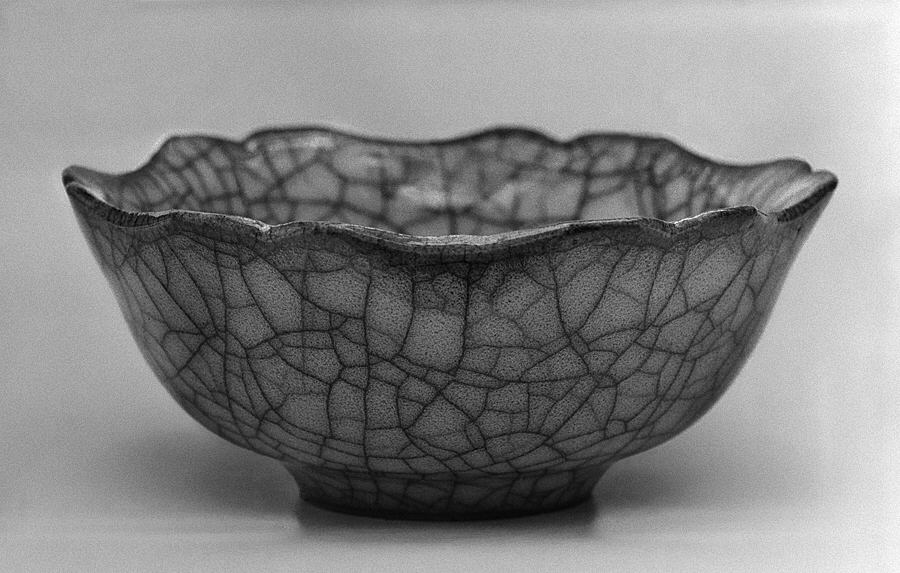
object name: dish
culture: chinese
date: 960-1279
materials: pottery